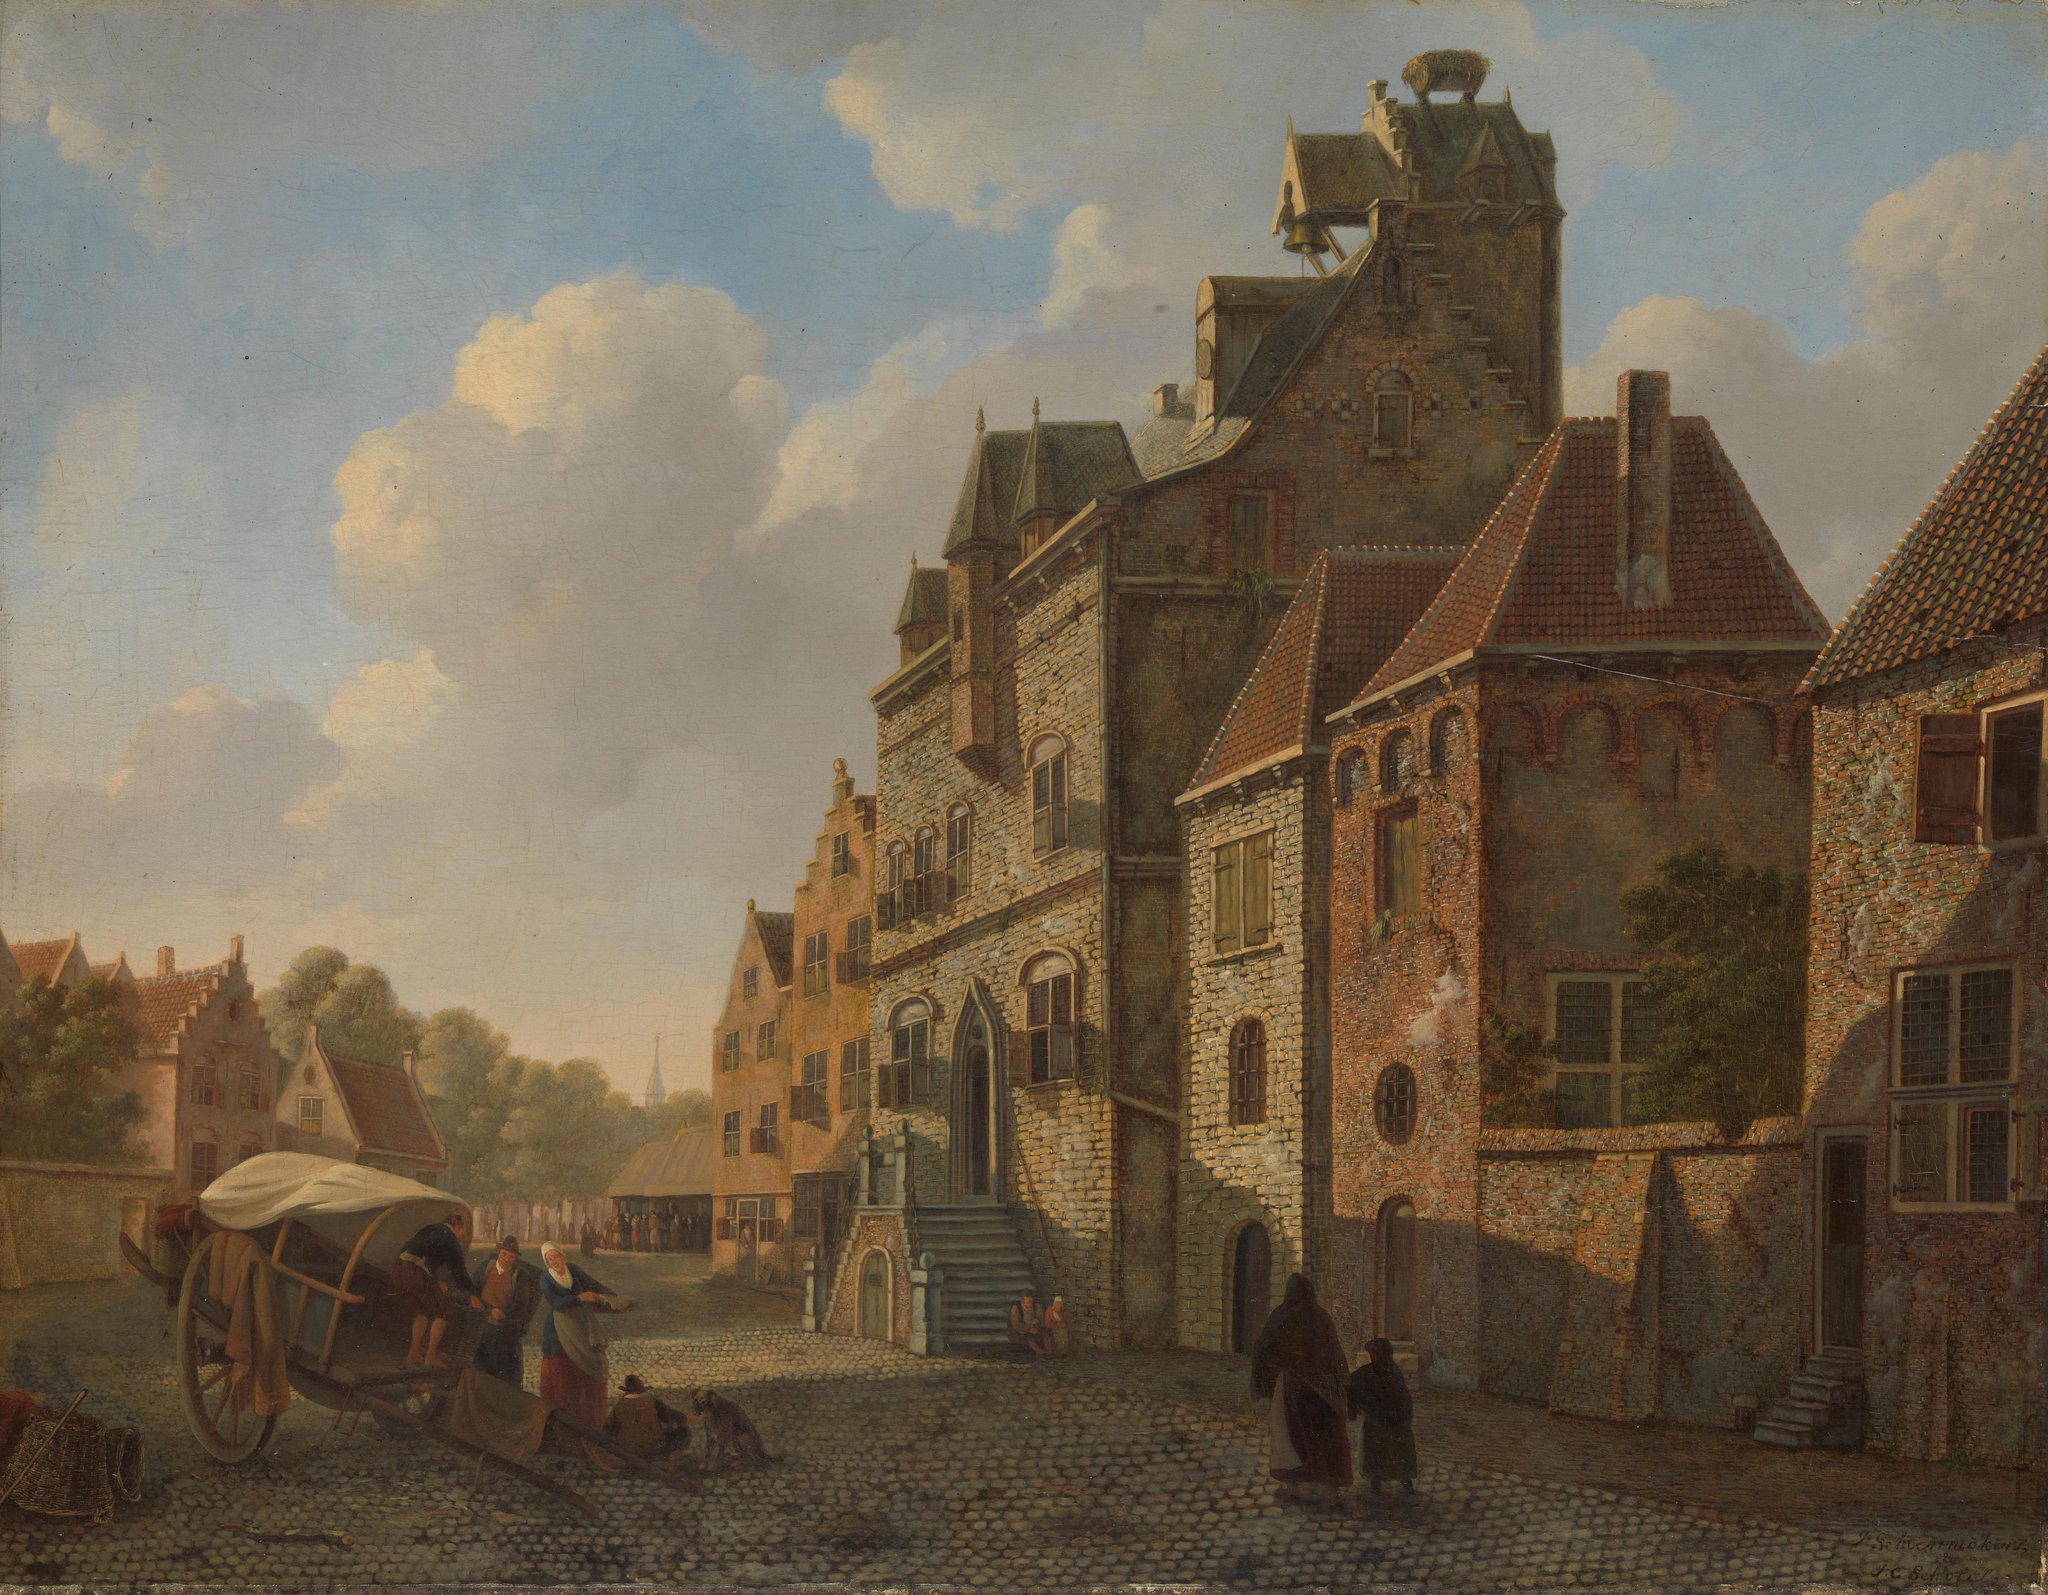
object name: painting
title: View in Dordrecht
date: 1819-1821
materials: oil, panel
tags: public road, dordrecht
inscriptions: signature: ‘J. Schoenmakers en J.C. Schotel’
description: Stadsgezicht te Dordrecht met het stadhuis en enkele andere gebouwen. Op straat enkele figuren bij een wagen.